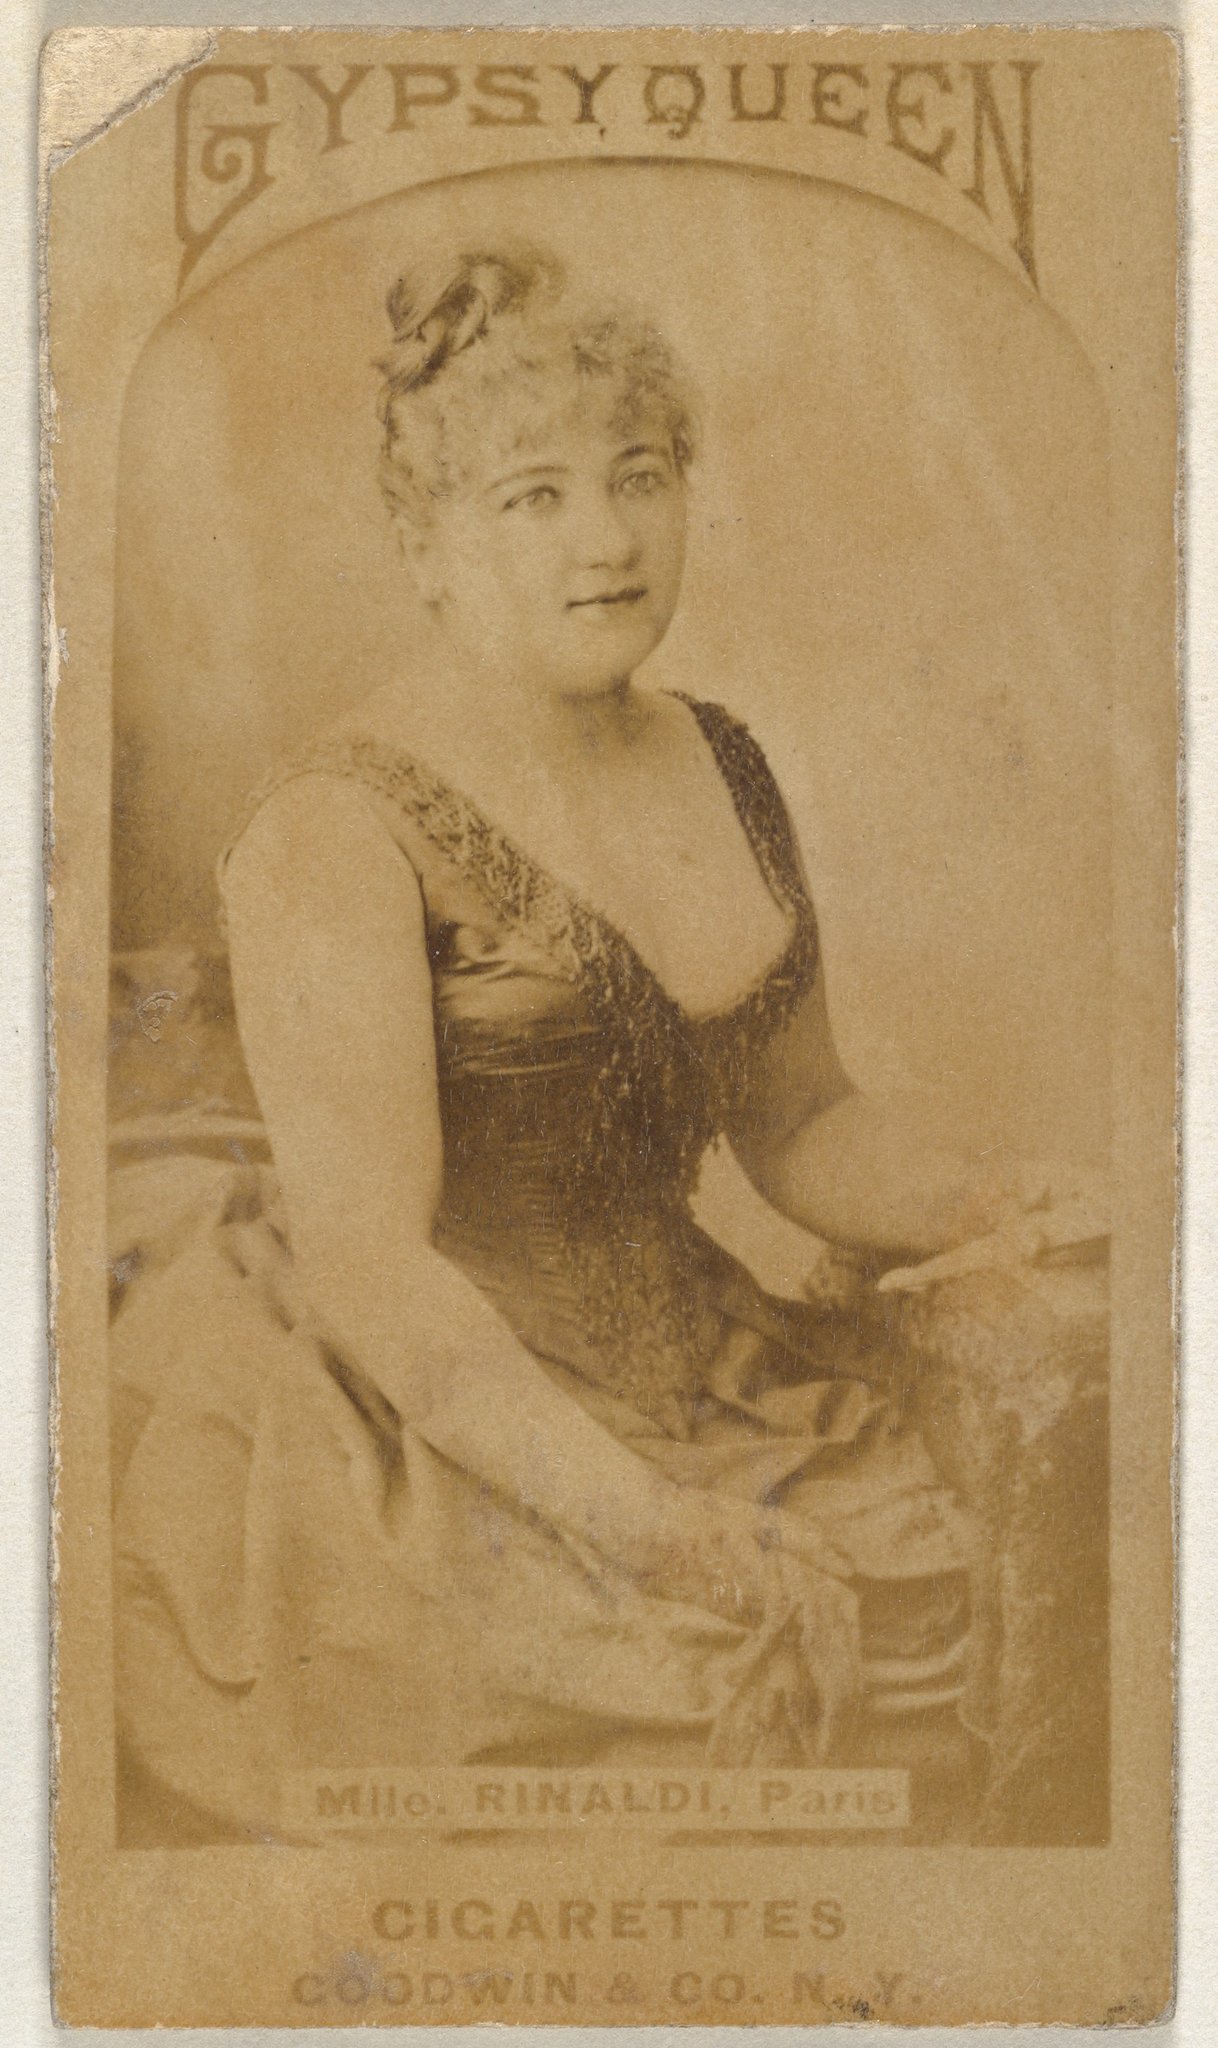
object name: photograph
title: Mlle. Rinaldi, Paris, from the Actors and Actresses series (N171) for Gypsy Queen Cigarettes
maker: goodwin & company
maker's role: publisher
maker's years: 1850-1950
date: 1886-1890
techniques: albumen silver print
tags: portraits,women,actresses